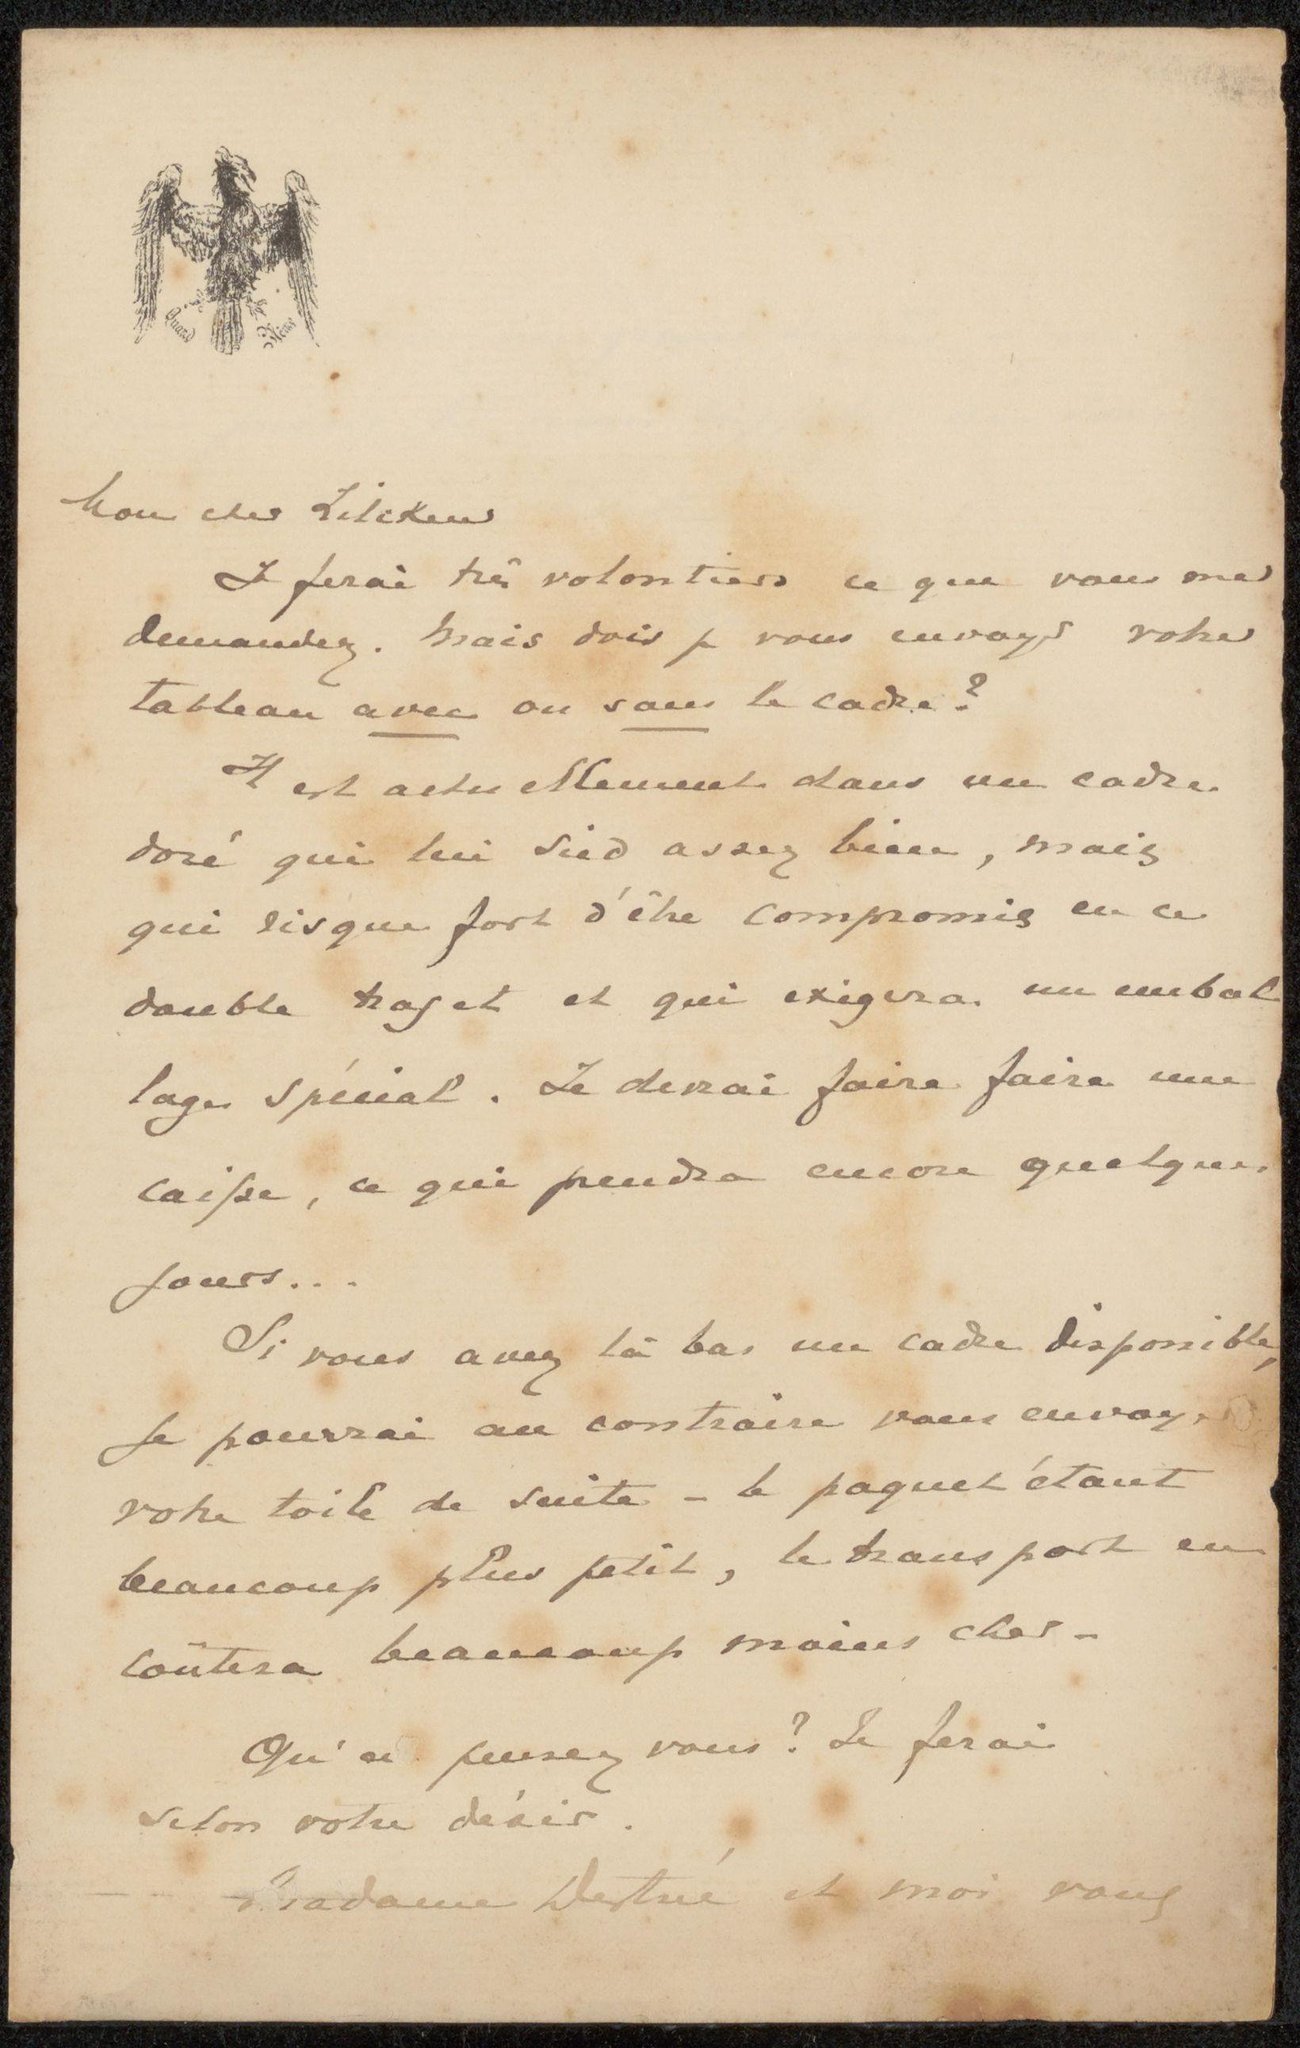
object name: letter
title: Brief aan Philip Zilcken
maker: jules destrée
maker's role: politician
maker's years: 1863-1936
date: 1873-1930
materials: ink, paper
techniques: pen, writing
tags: the hague, painter, draughtsman, philip zilcken, painting (including book-illumination, miniature-painting)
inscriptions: collector's mark: ‘RPK’, motto: ‘RPK’